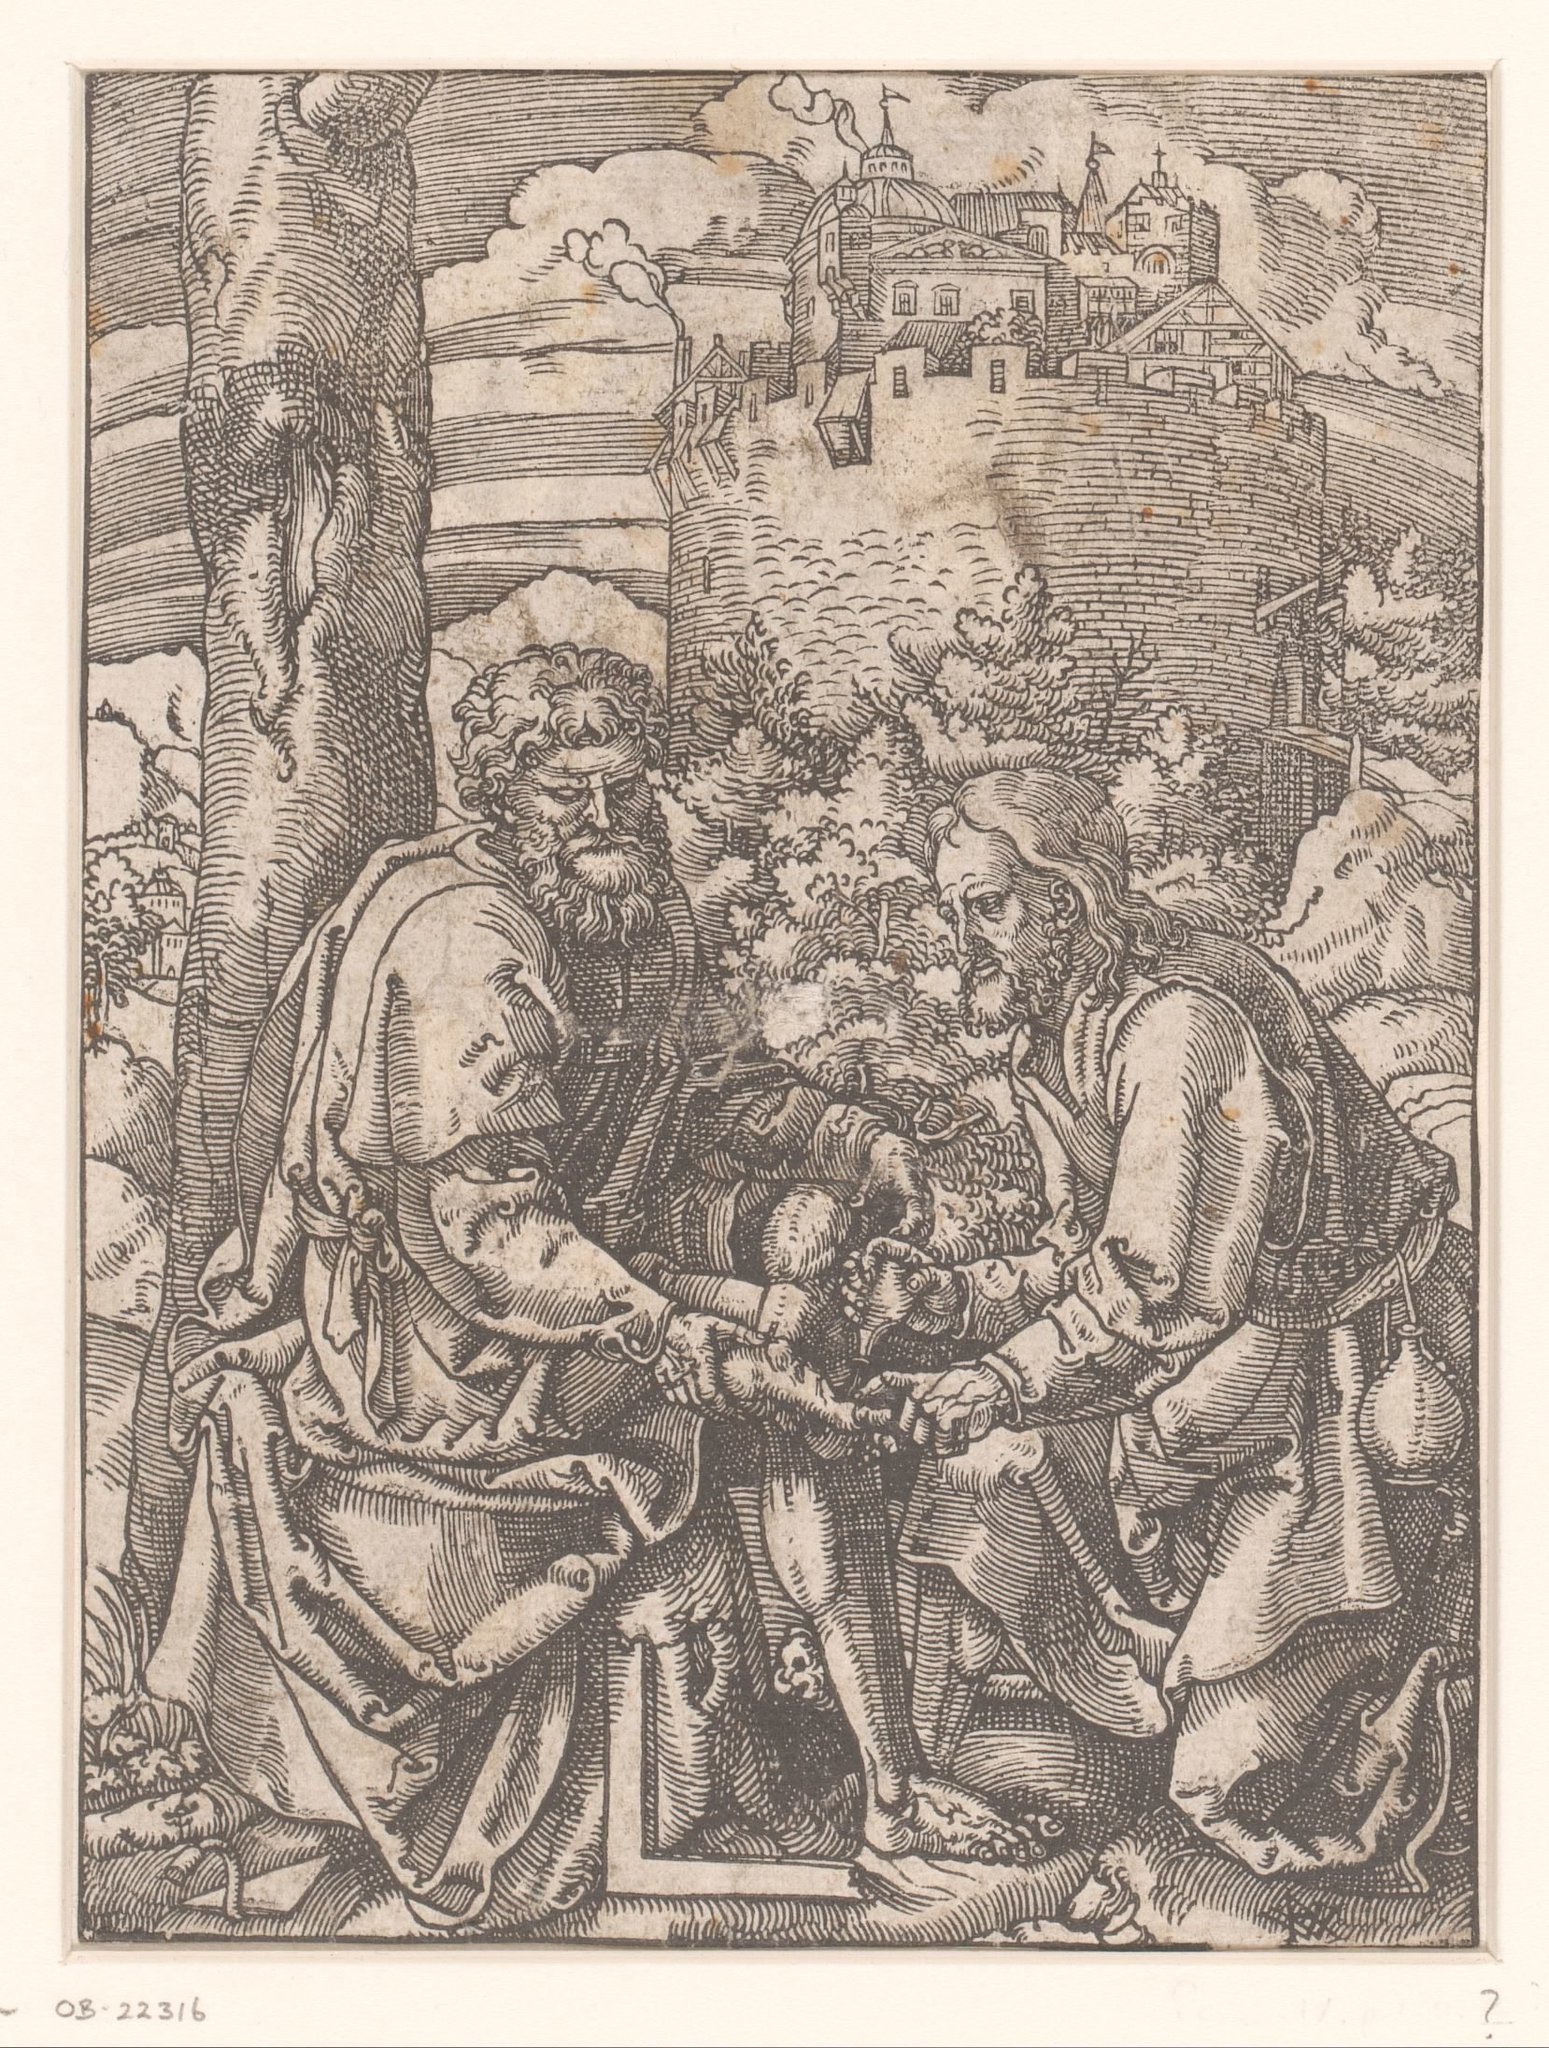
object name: print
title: Christus zalft de voeten van een zittende man met als attributen een troffel en een winkelhaak; misschien Christus die de apostel Thomas troost op zijn reis naar India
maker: Anonymous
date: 1524-1534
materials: paper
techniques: woodcut